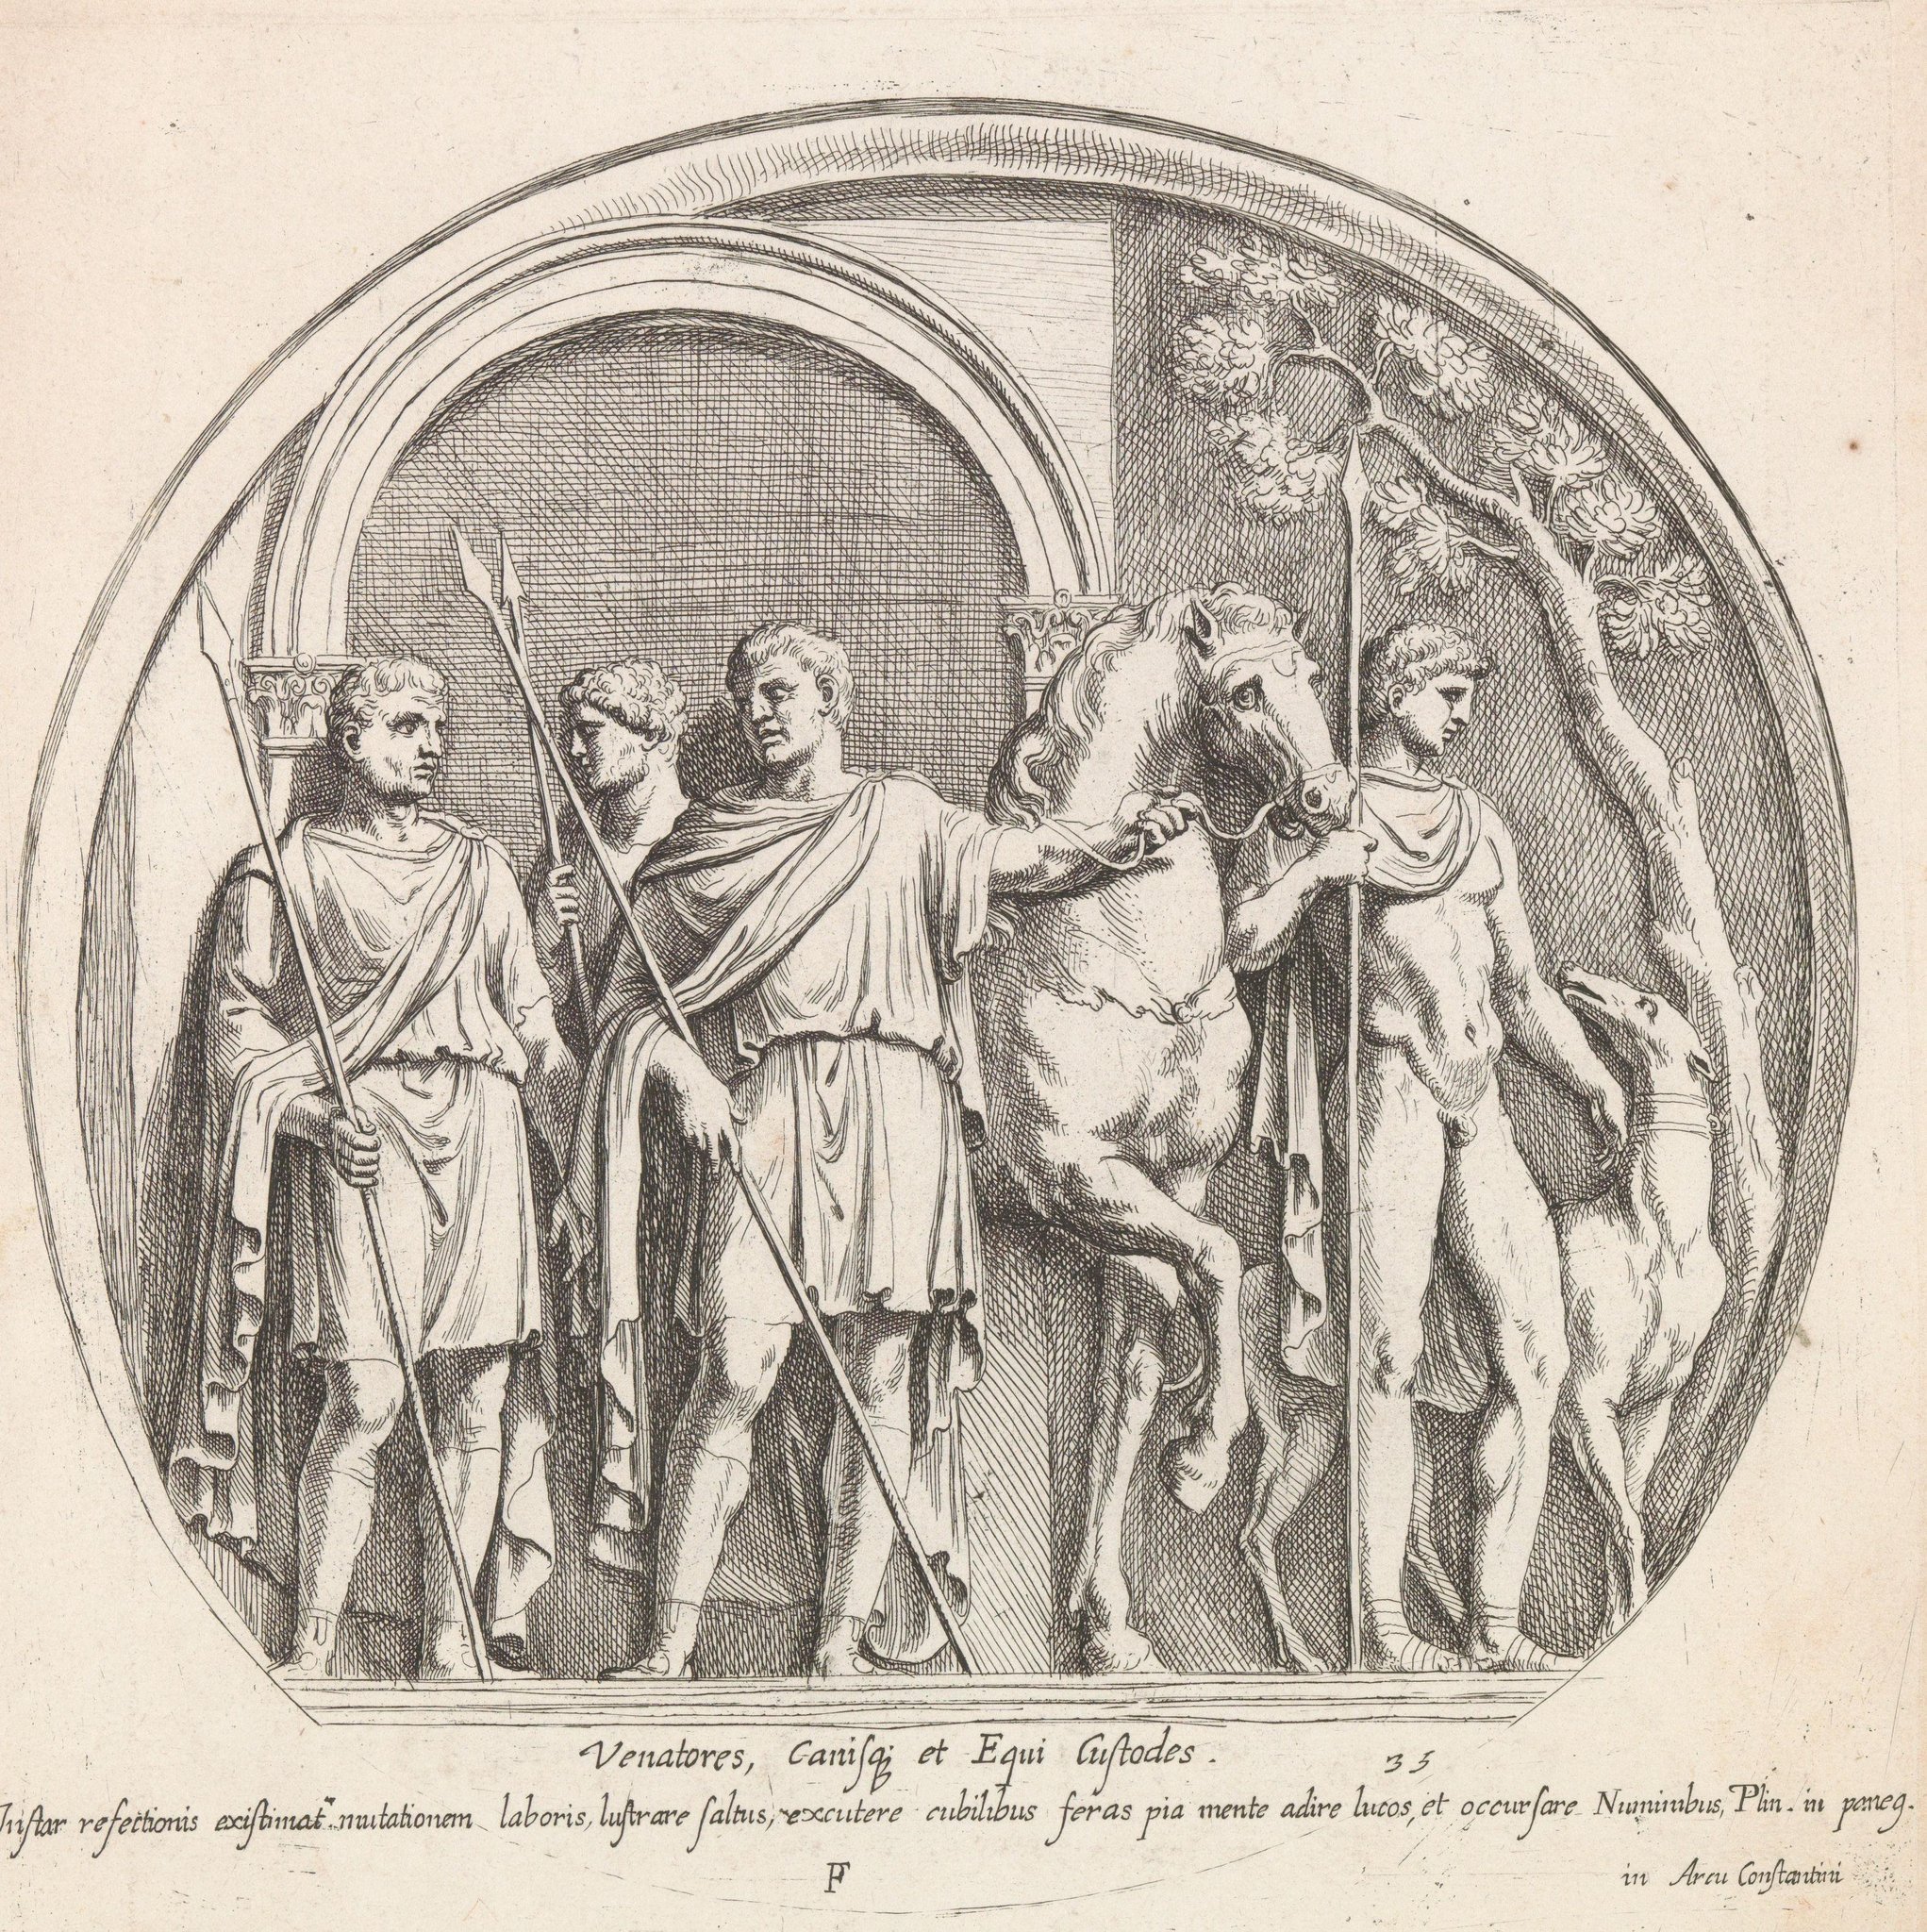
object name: print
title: Reliëf met een Romeinse keizer die vertrekt voor de jacht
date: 1645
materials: paper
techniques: etching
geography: paris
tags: hunter, hunters hunting (n.b.: in 1988-1990 this notation denoted the concept of 43c11421 'hunters resting during the hunt'), piece of sculpture, reproduction of a piece of sculpture, ruler, sovereign, arch of constantine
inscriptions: inscription: ‘Ende lib. No. 12. fol. 19. lib. No. 14. fol. 62./ Ende lib. No. 5. fol. 74. 75. 111. 115...’, number: ‘62’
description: Reliëf met een Romeinse keizer die vertrekt voor de jacht. De keizer staat naast zijn paard en draagt een speer. Rechts een jonge jager en een hond. Links twee mannen met speren. Tekst in het Latijn in ondermarge. Prent maakt deel uit van een album.